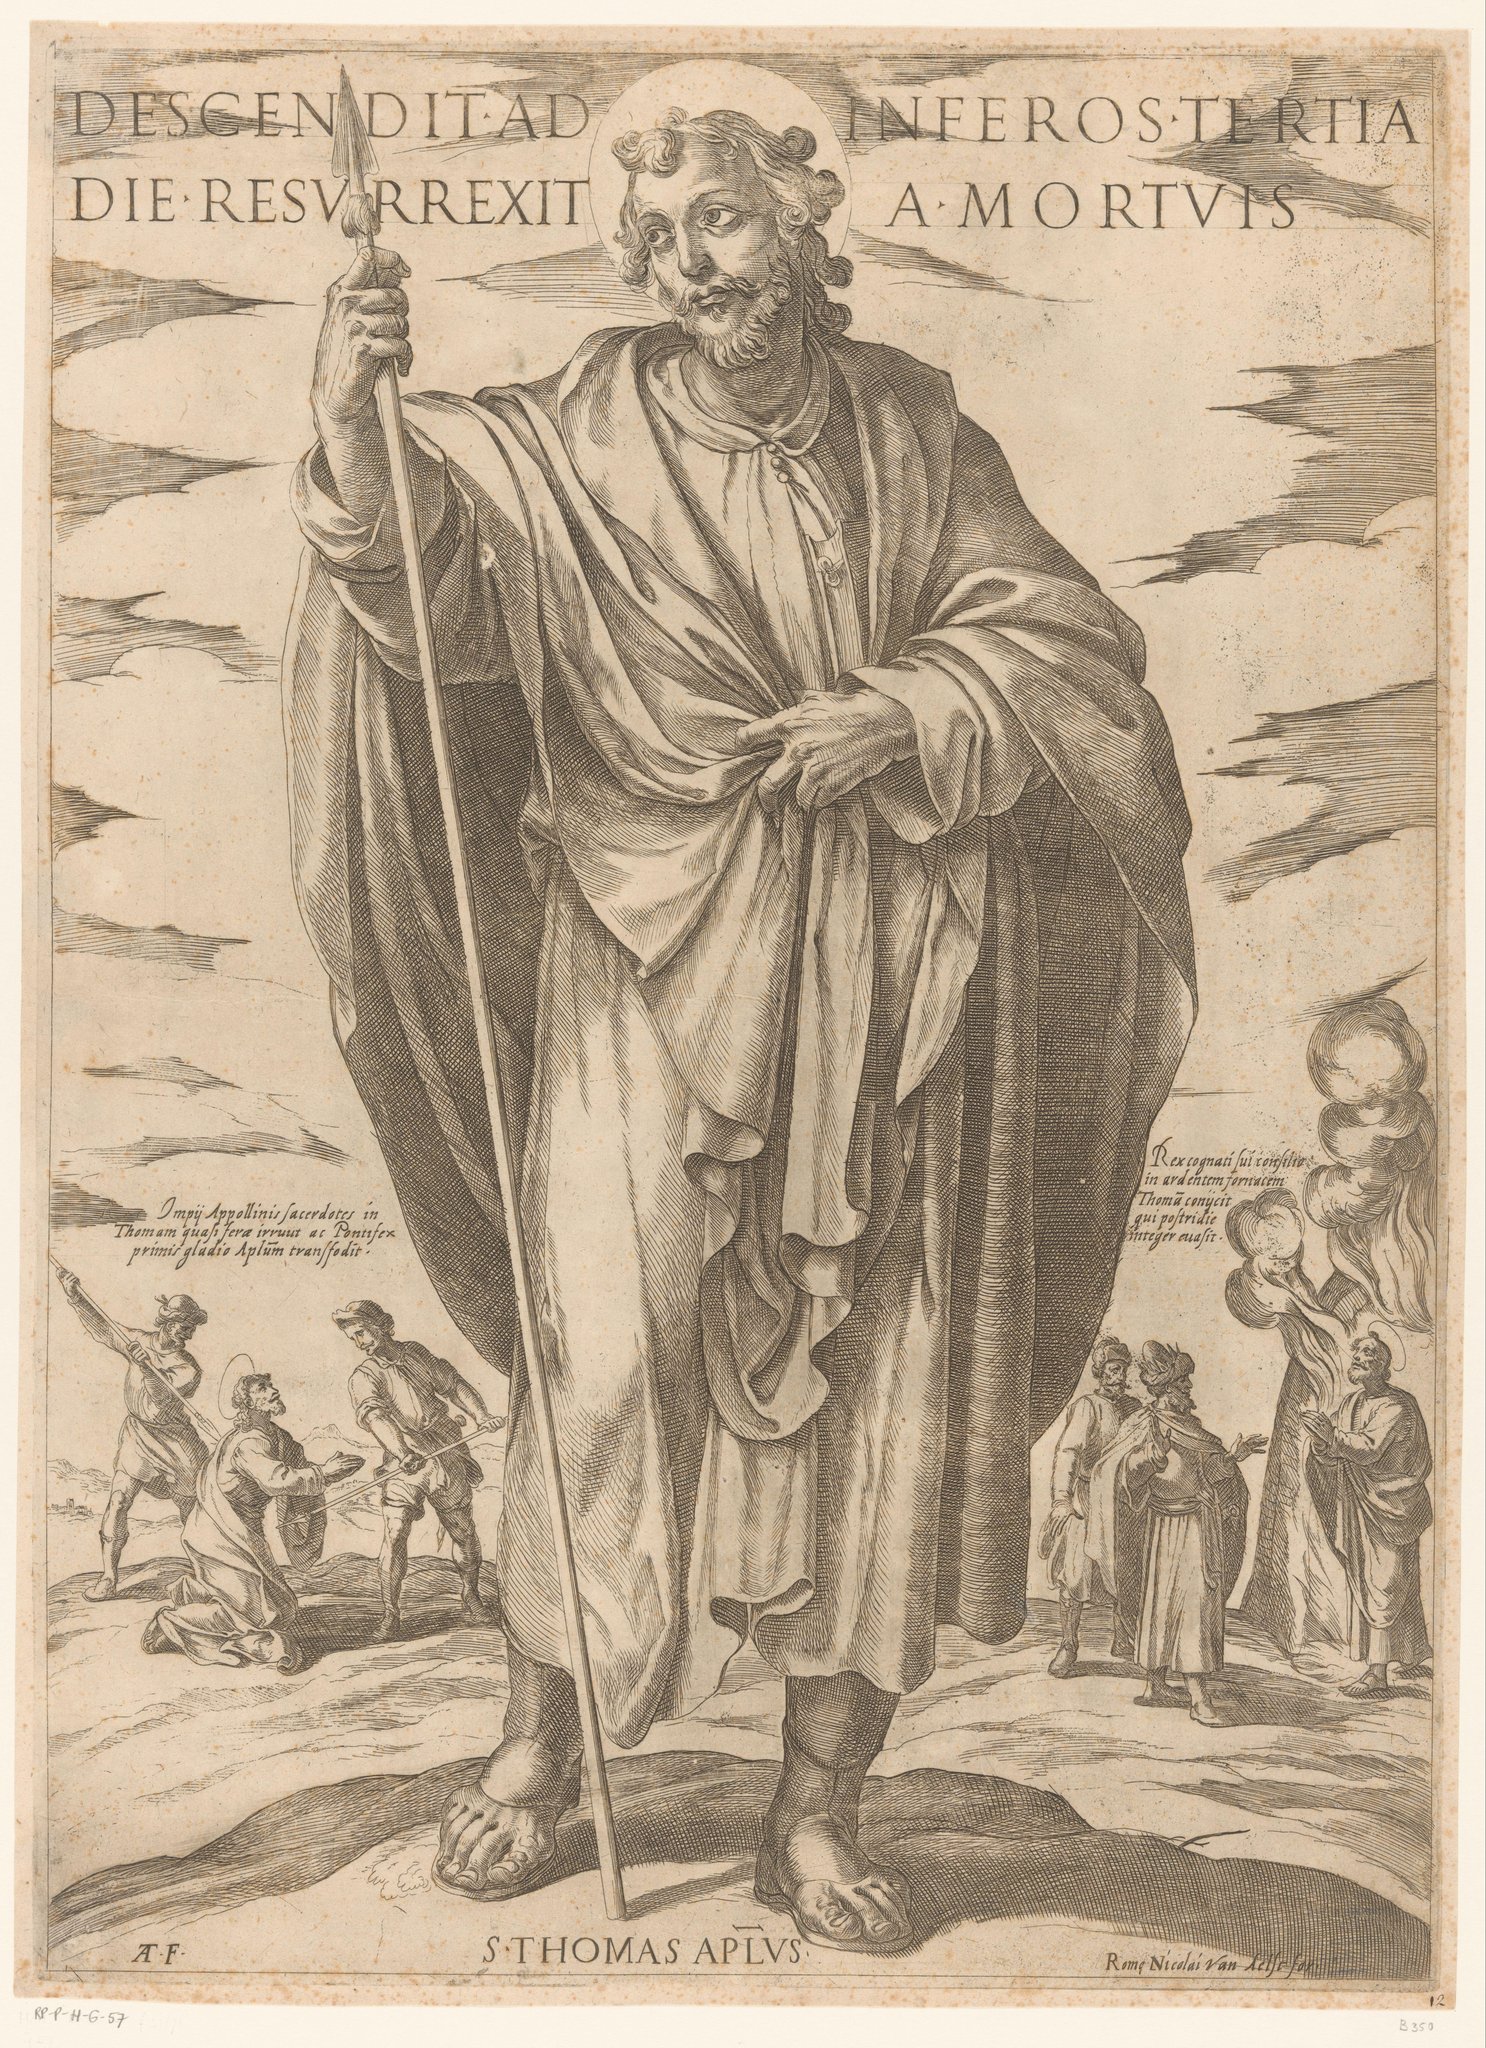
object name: print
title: Descendit ad inferos tertia die resurrexit a mortuis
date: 1565-1630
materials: paper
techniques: etching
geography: rome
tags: the apostle thomas; possible attributes: book, chalice, girdle, heart, lance or spear, scroll, square, stones, miracles of thomas, martyrdom and death of thomas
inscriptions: collector's mark: ‘Hinloopen’, number: ‘12’, collector's mark: Lugt 11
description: De heilige Tomas met boek en speer. Op de achtergrond links wordt Tomas dood gestoken door twee mannen met speren. Op de achtergrond rechts verricht Tomas een wonder in India.